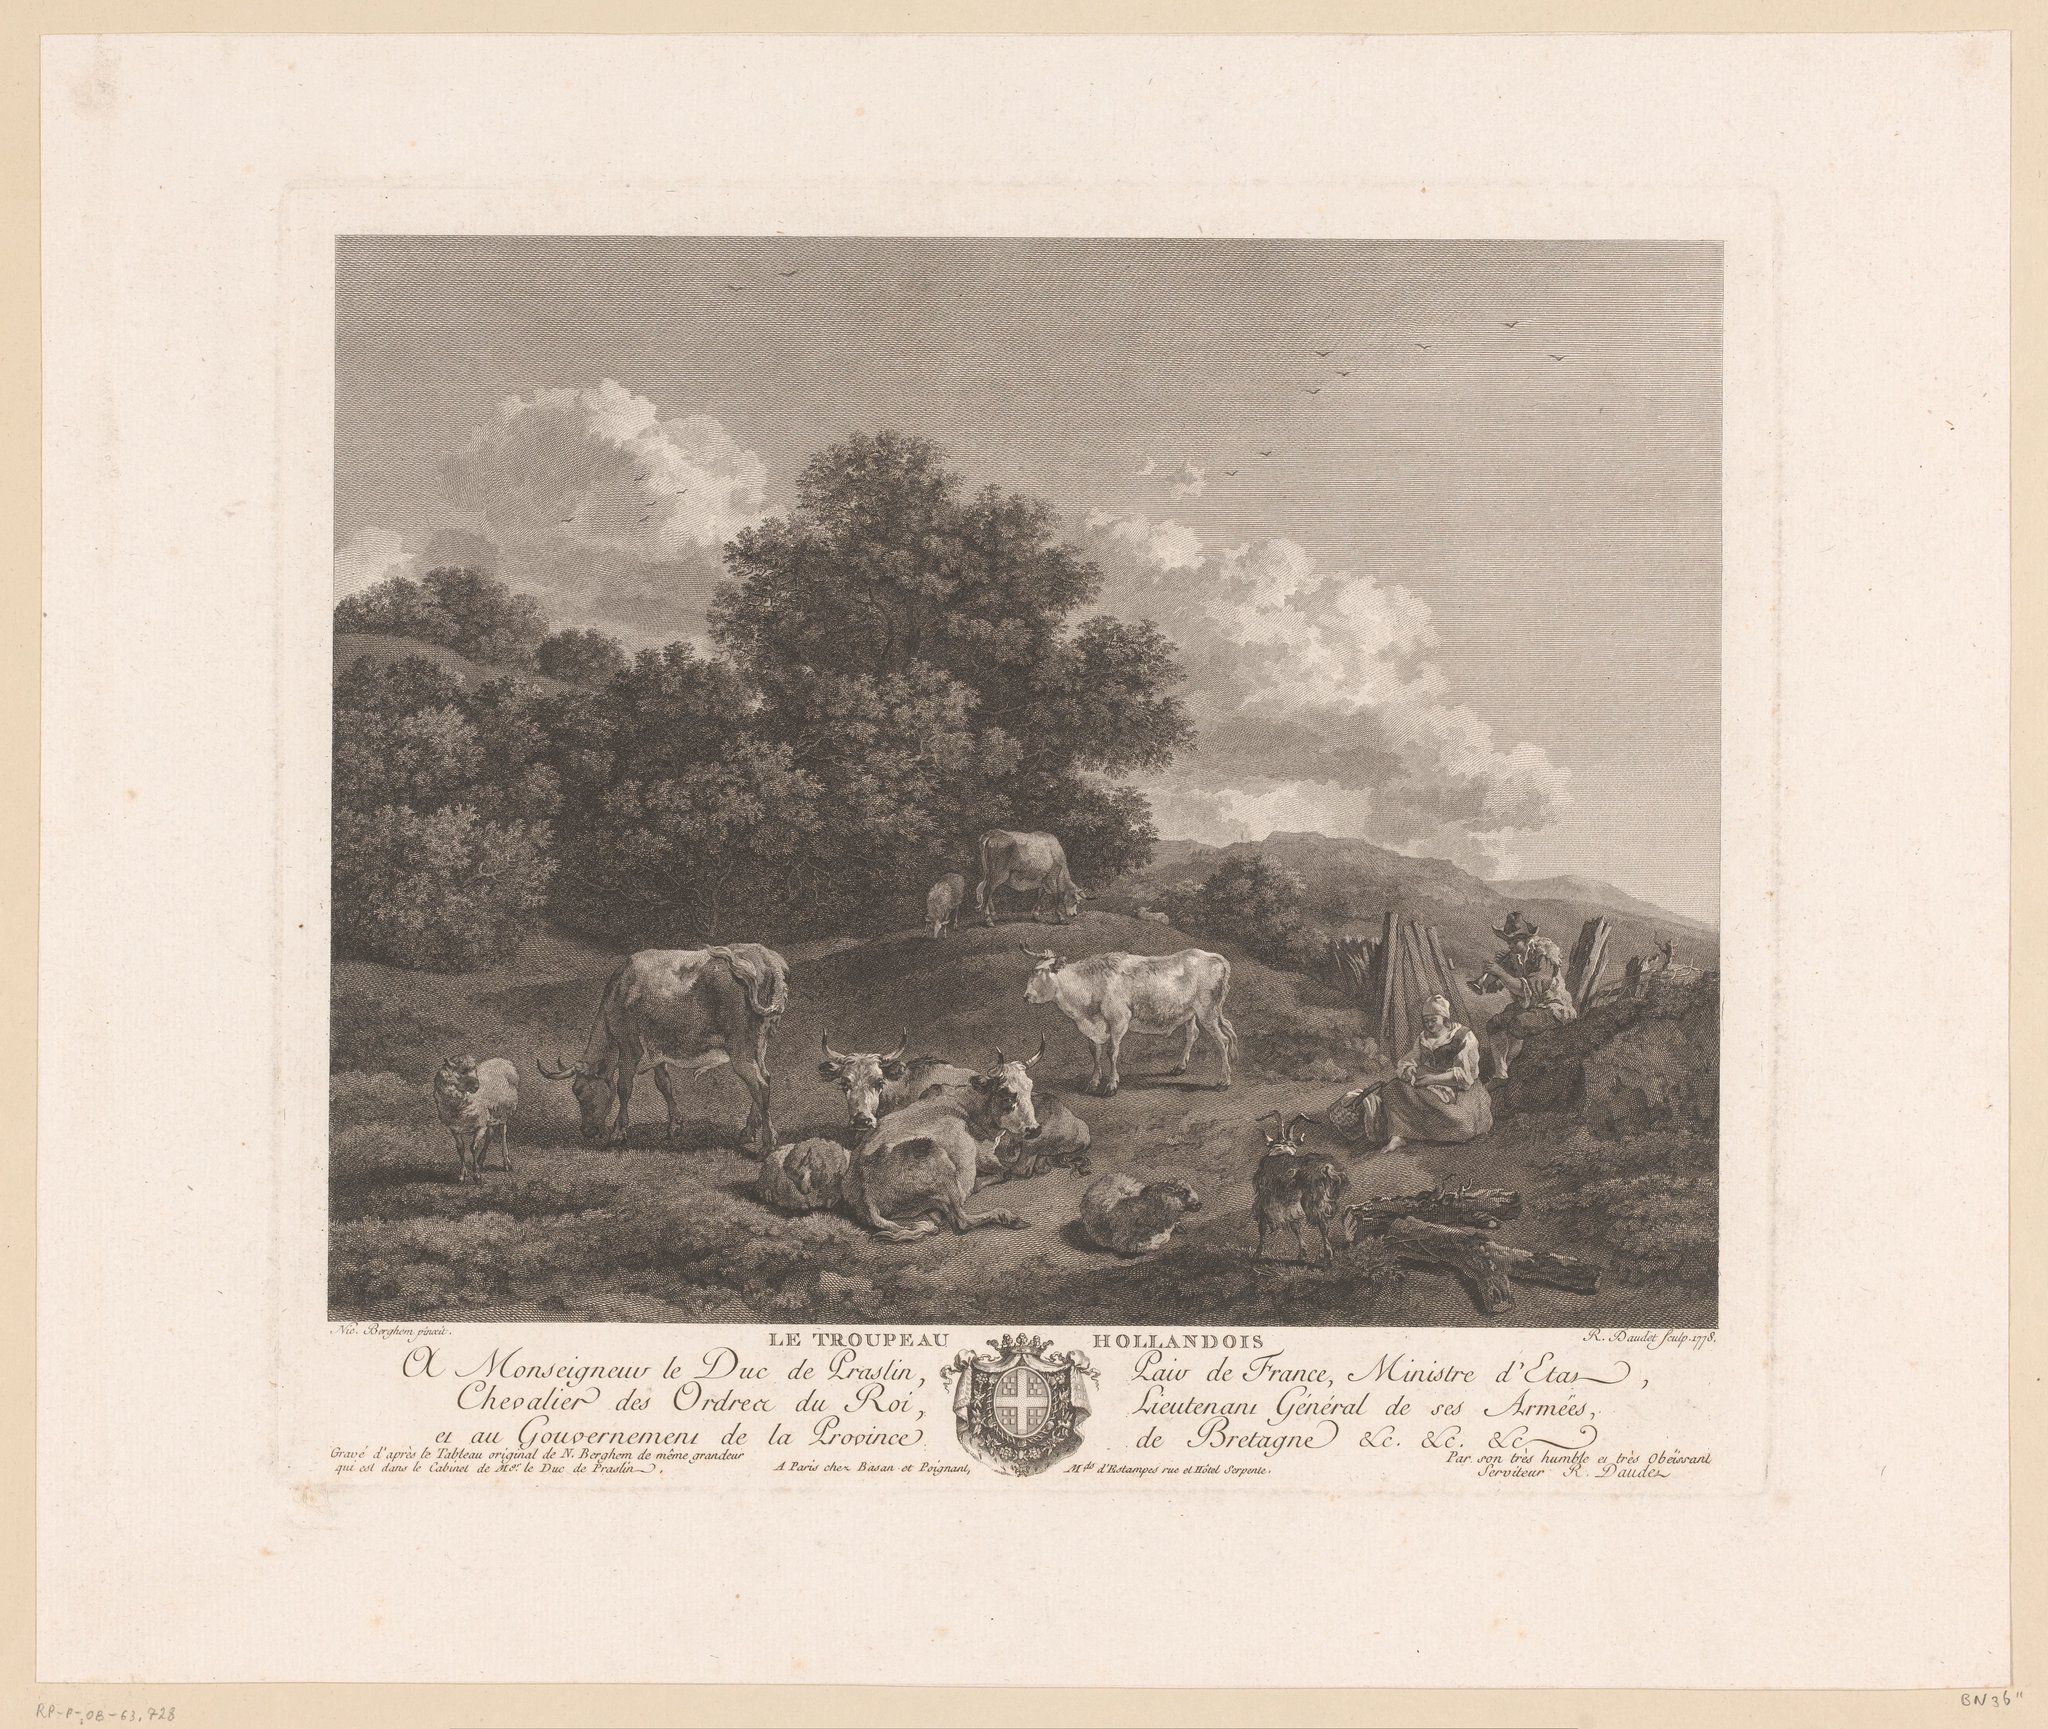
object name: print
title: Le troupeau hollandois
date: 1778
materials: paper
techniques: engraving, etching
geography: france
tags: landscapes, herding, herdsman, herdswoman, shepherd, shepherdess, cowherd, etc., herd, flock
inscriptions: collector's mark: Lugt 240